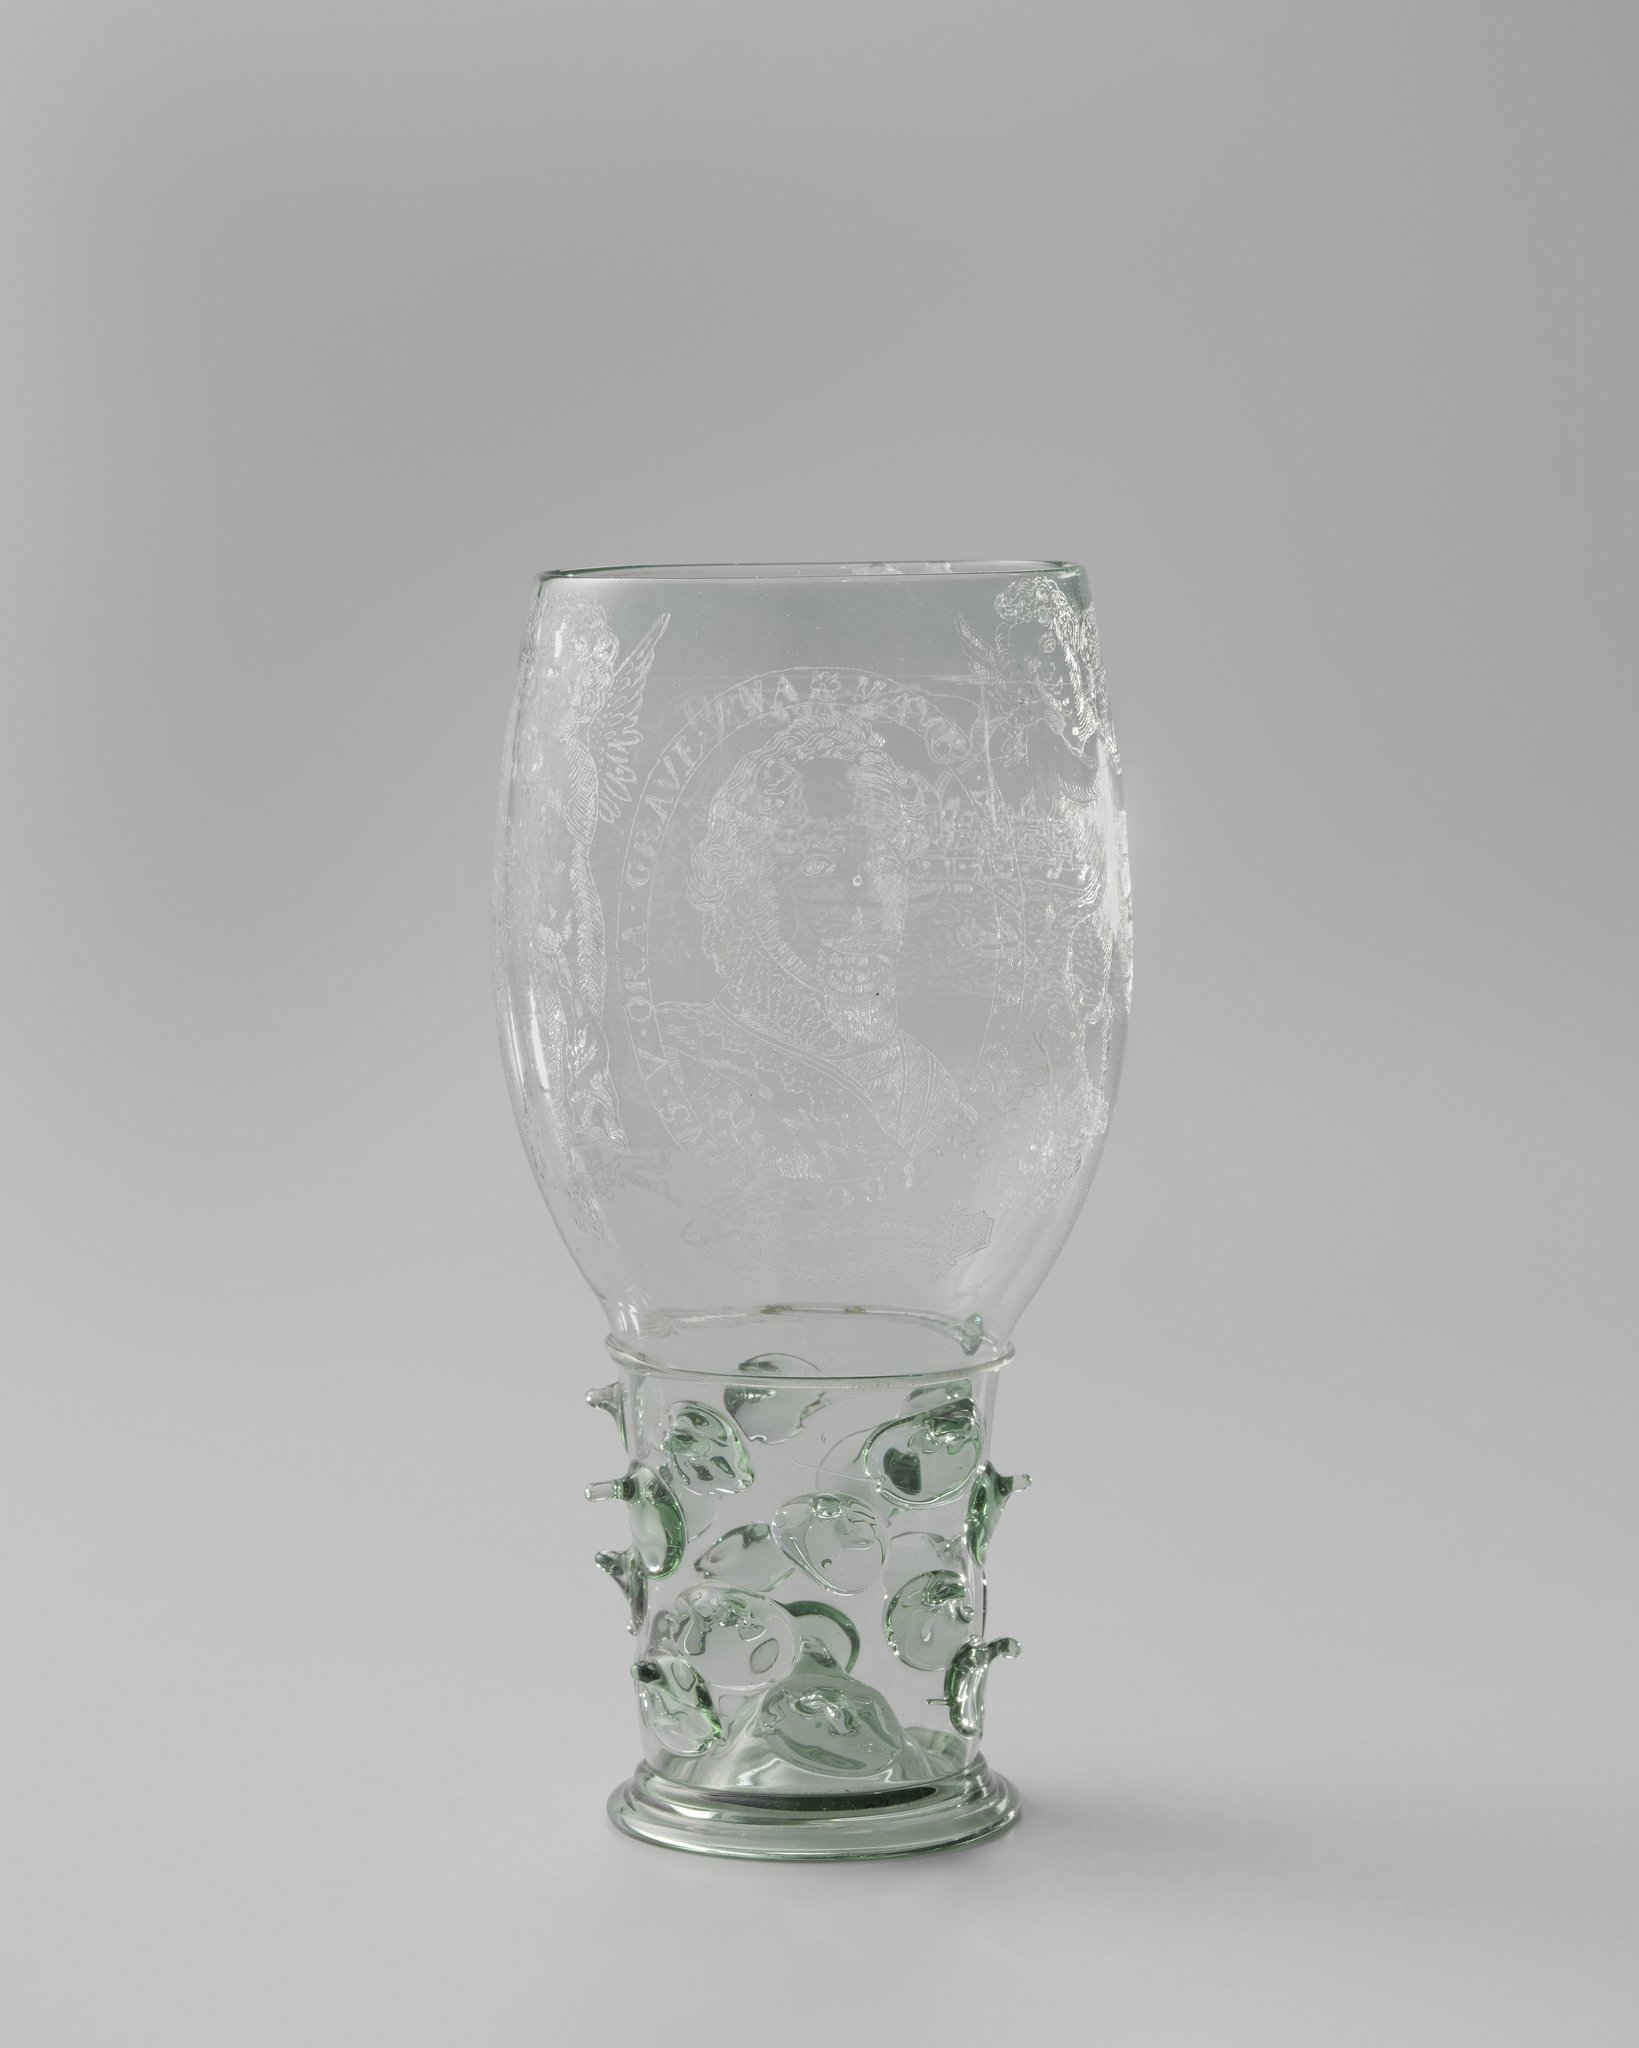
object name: roemer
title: Roemer with a Portrait of Prince Maurice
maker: Anonymous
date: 1618-1625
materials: glass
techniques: diamond point engraving, glassblowing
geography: northern netherlands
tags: the hague, maurice (prince of orange), historical persons (+ head (and shoulders) (portrait)), city-view in general; 'veduta', dordrecht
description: In the calligraphic inscription to his portrait, Maurice is called ‘Prince of Orange’, the title he inherited after the death of his half-brother Phillip William in 1618. The clasped hands signify friendship, the parrot may refer to the eloquence of the person giving a toast with this glass, and the butterfly stands for the fleetingness of life.